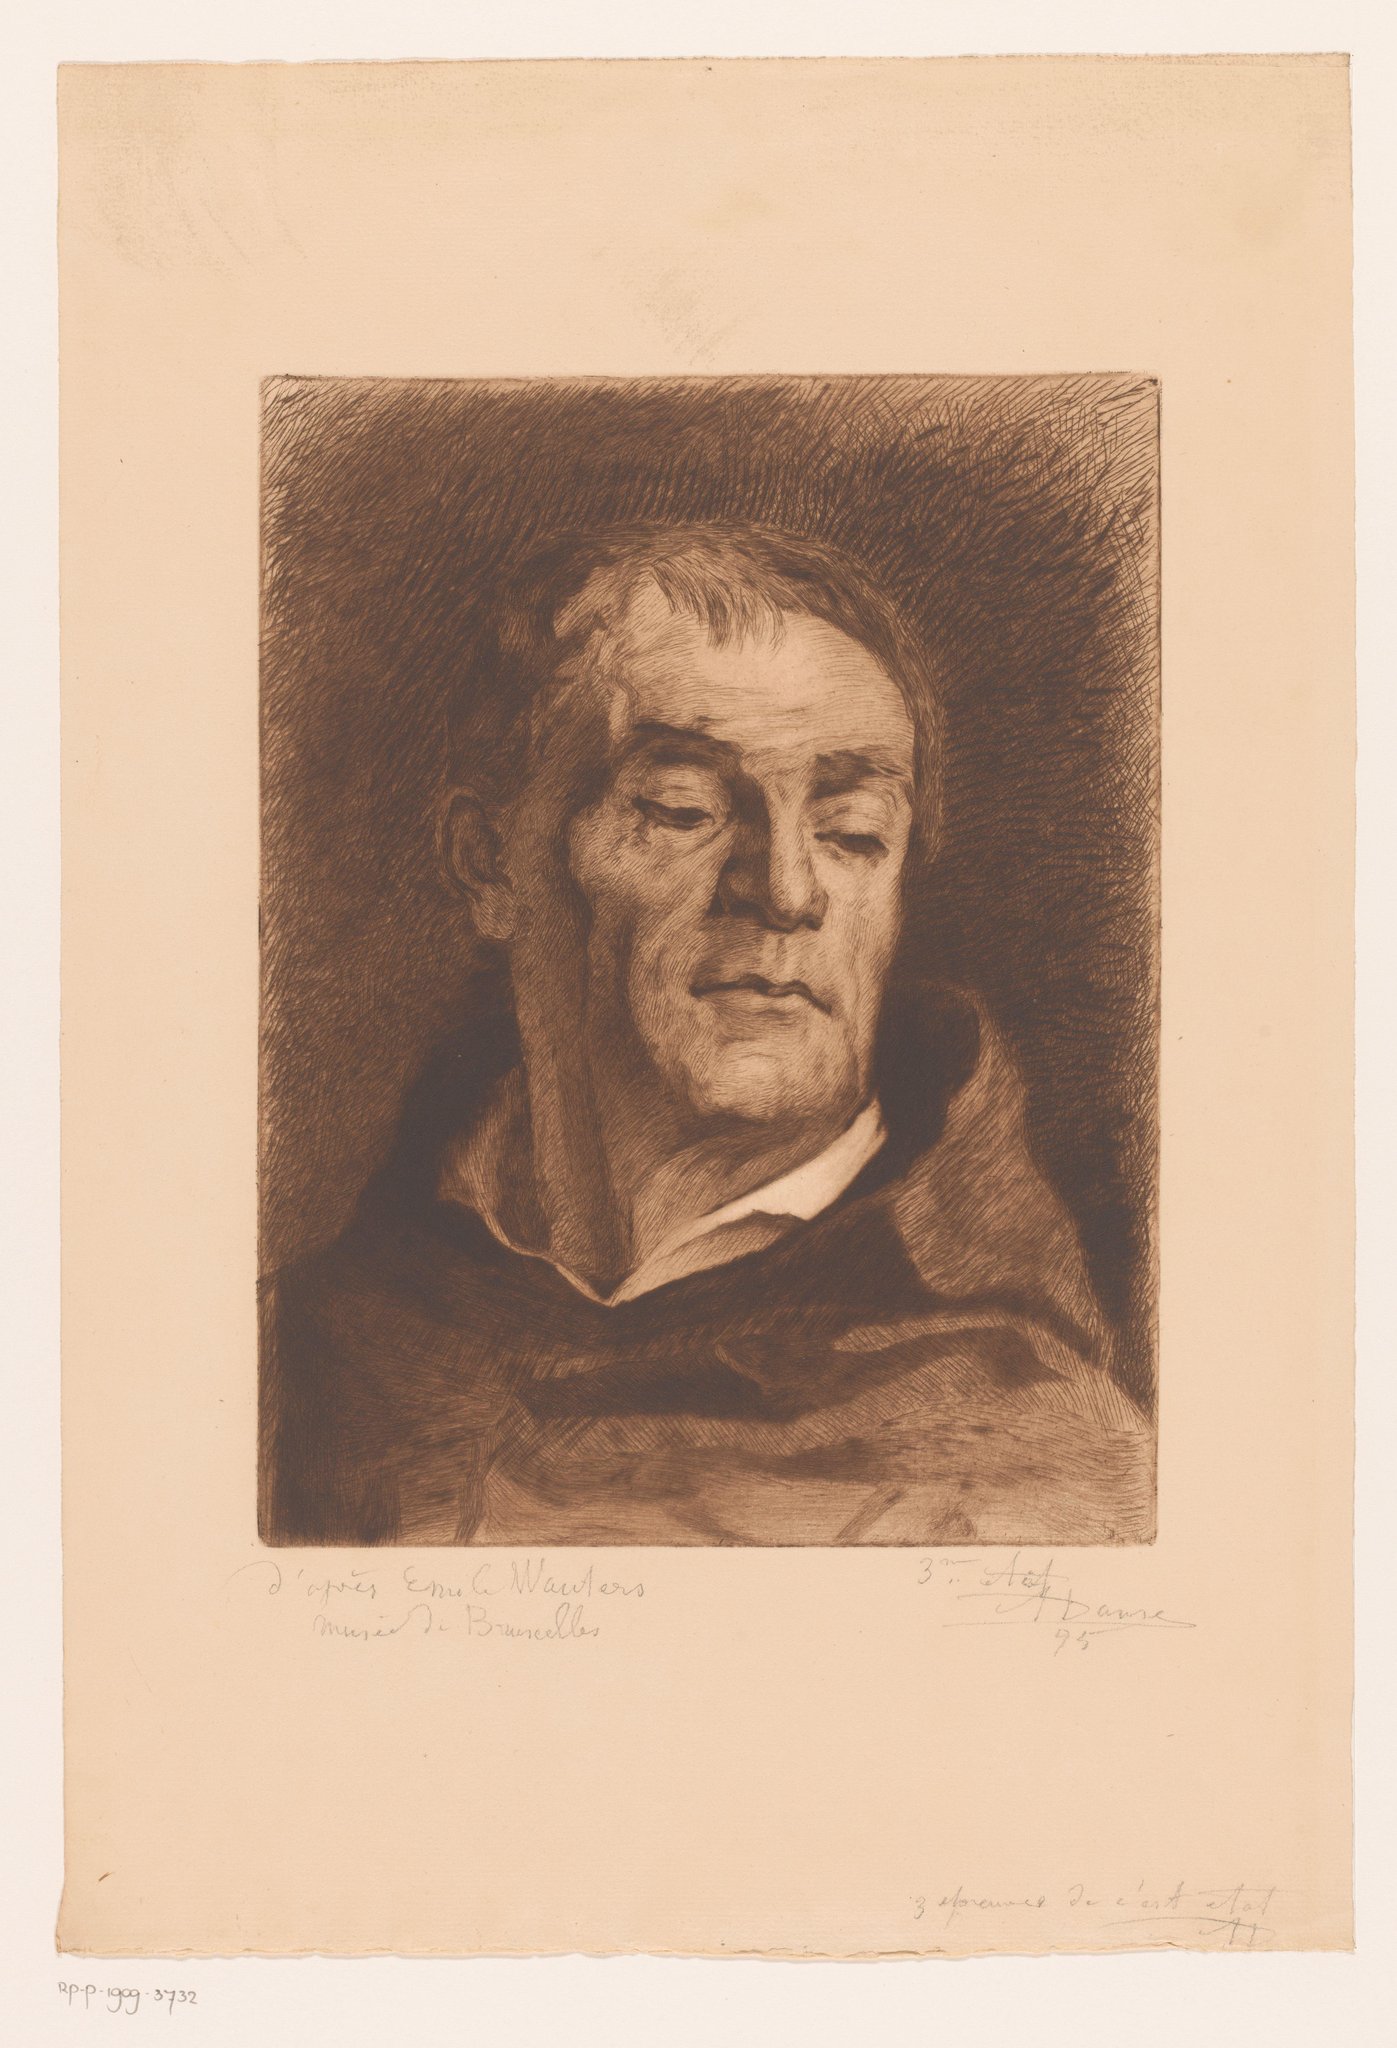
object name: print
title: Hoofd van een monnik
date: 1895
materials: paper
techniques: drypoint, etching, intaglio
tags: monk(s), friar(s)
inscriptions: annotation: ‘3me etat; 3 epreuves de c'est etat’, collector's mark: Lugt 2228